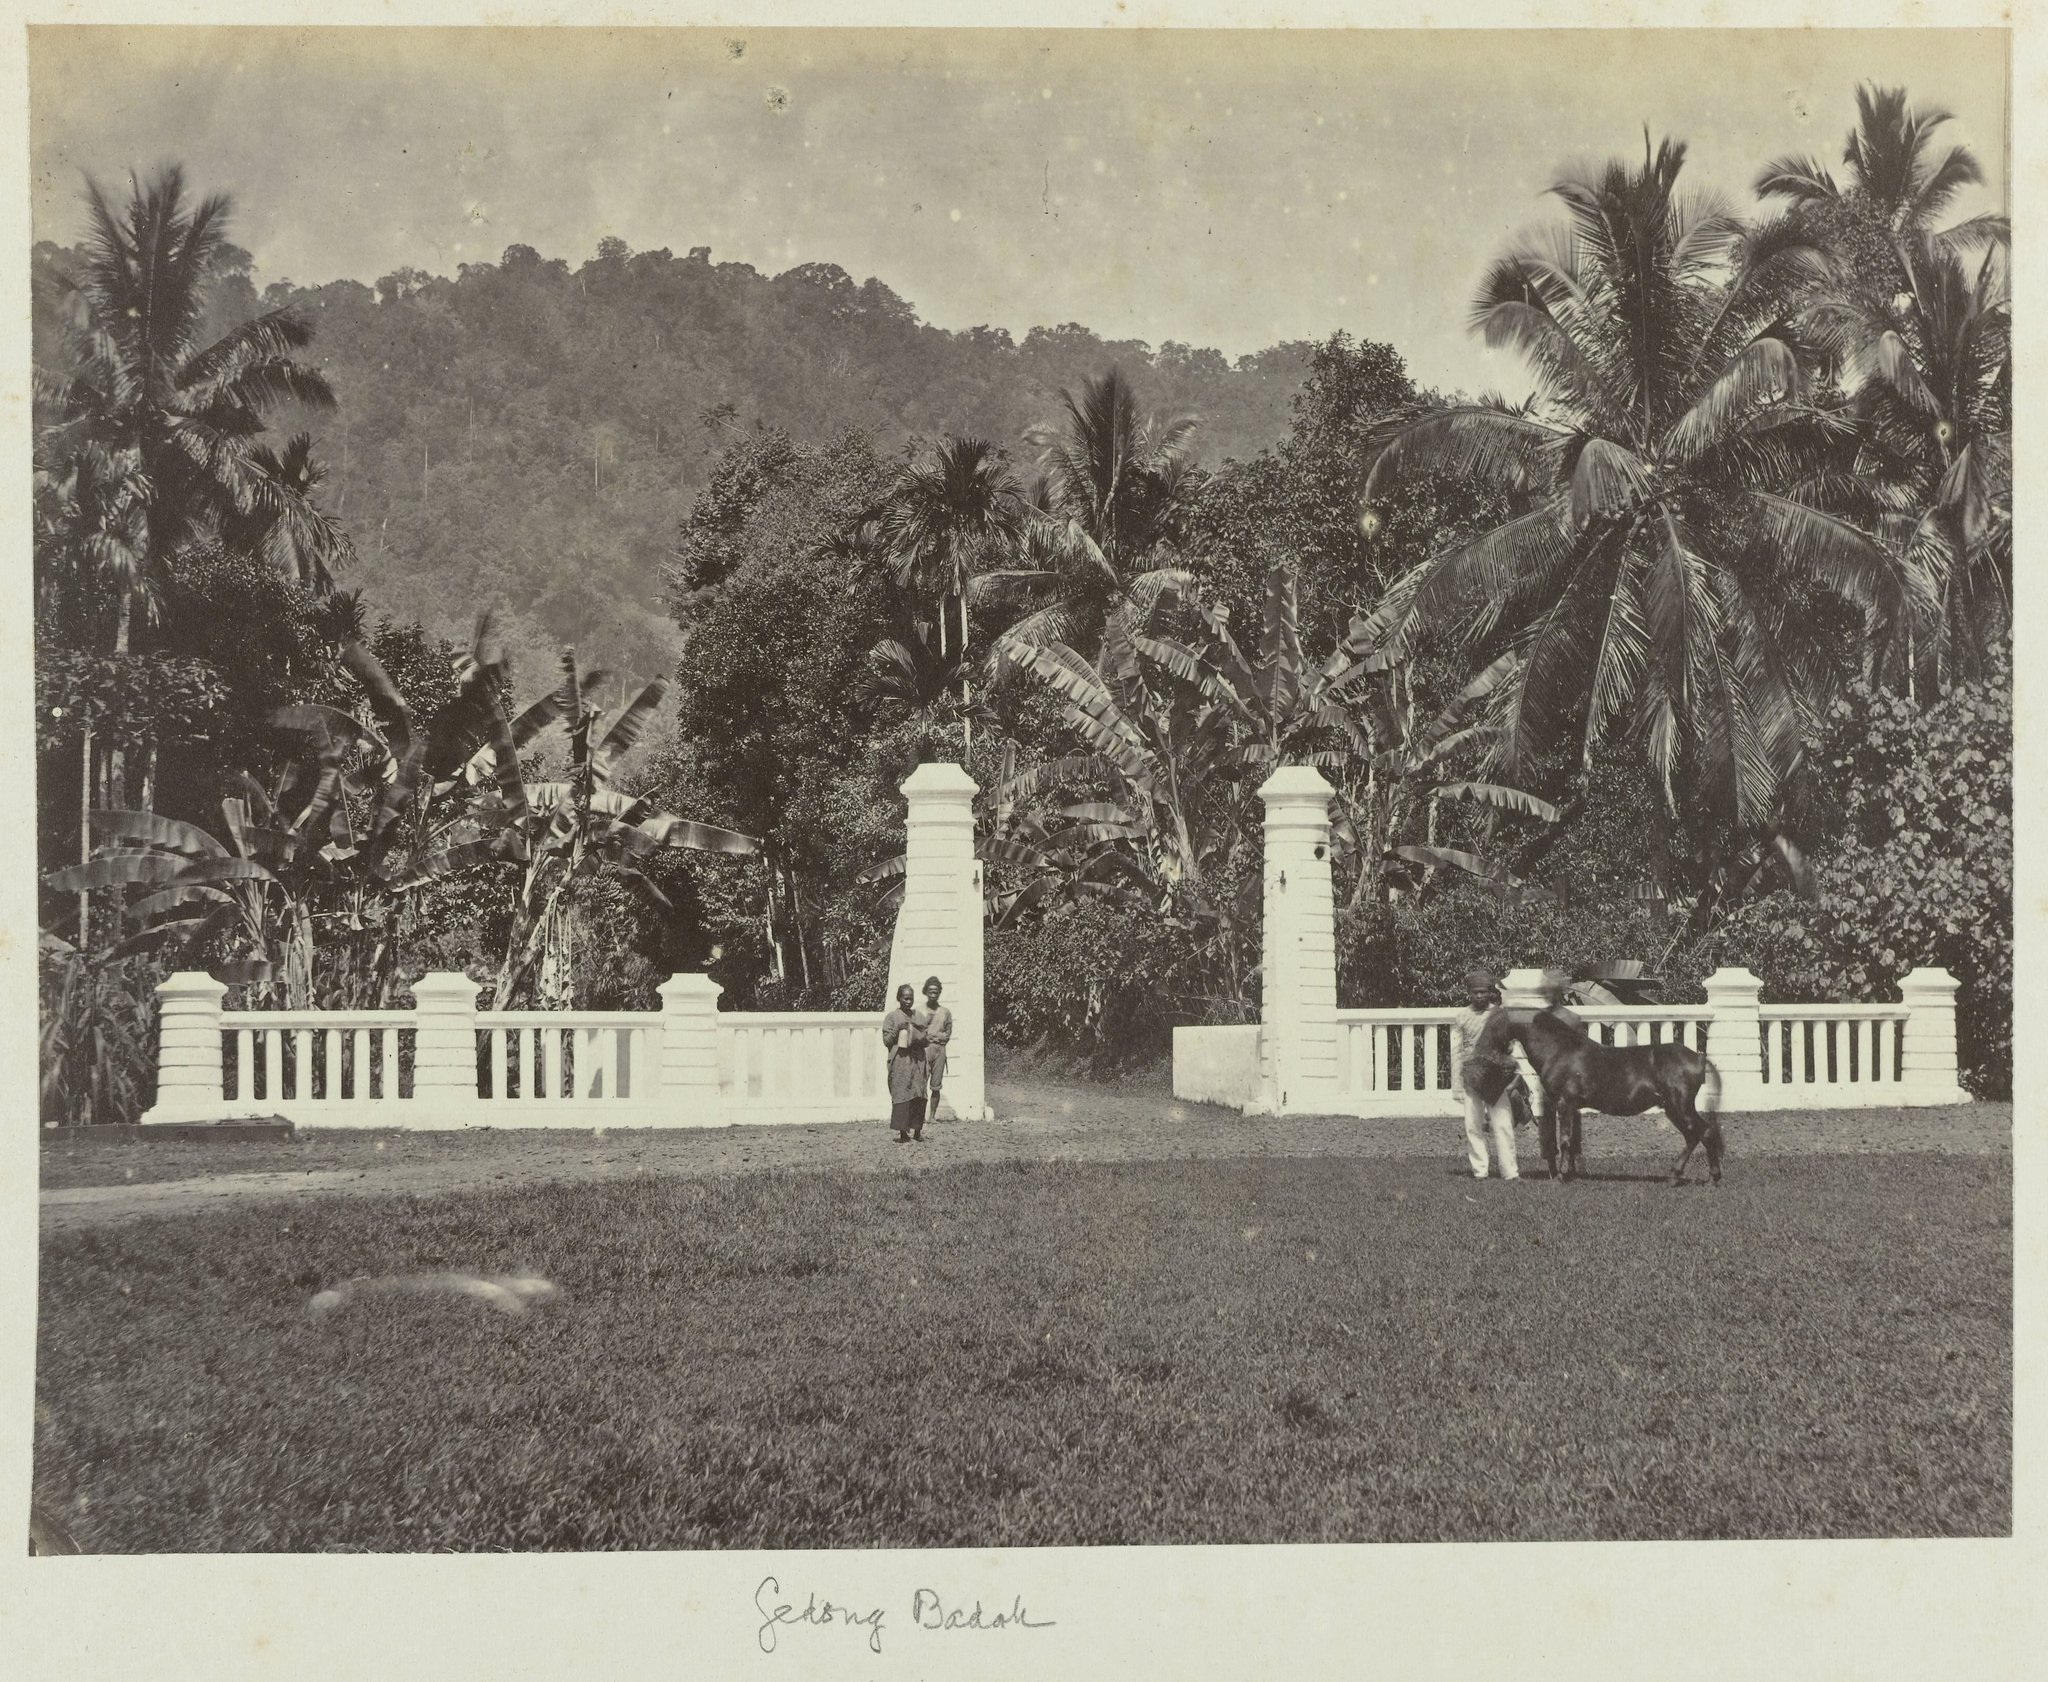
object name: photograph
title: Poort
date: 1863-1869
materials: photographic support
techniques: albumen print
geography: java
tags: java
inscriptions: inscription: ‘Gedong Badak’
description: Witte poort met zuilen en hek, mogelijk te Gedong Badak. Onderdeel van het groene fotoalbum met foto's van Java, uit het bezit van apotheker Specht-Grijp, die in 1865 vanuit Batavia naar Nederland terugkeerde.